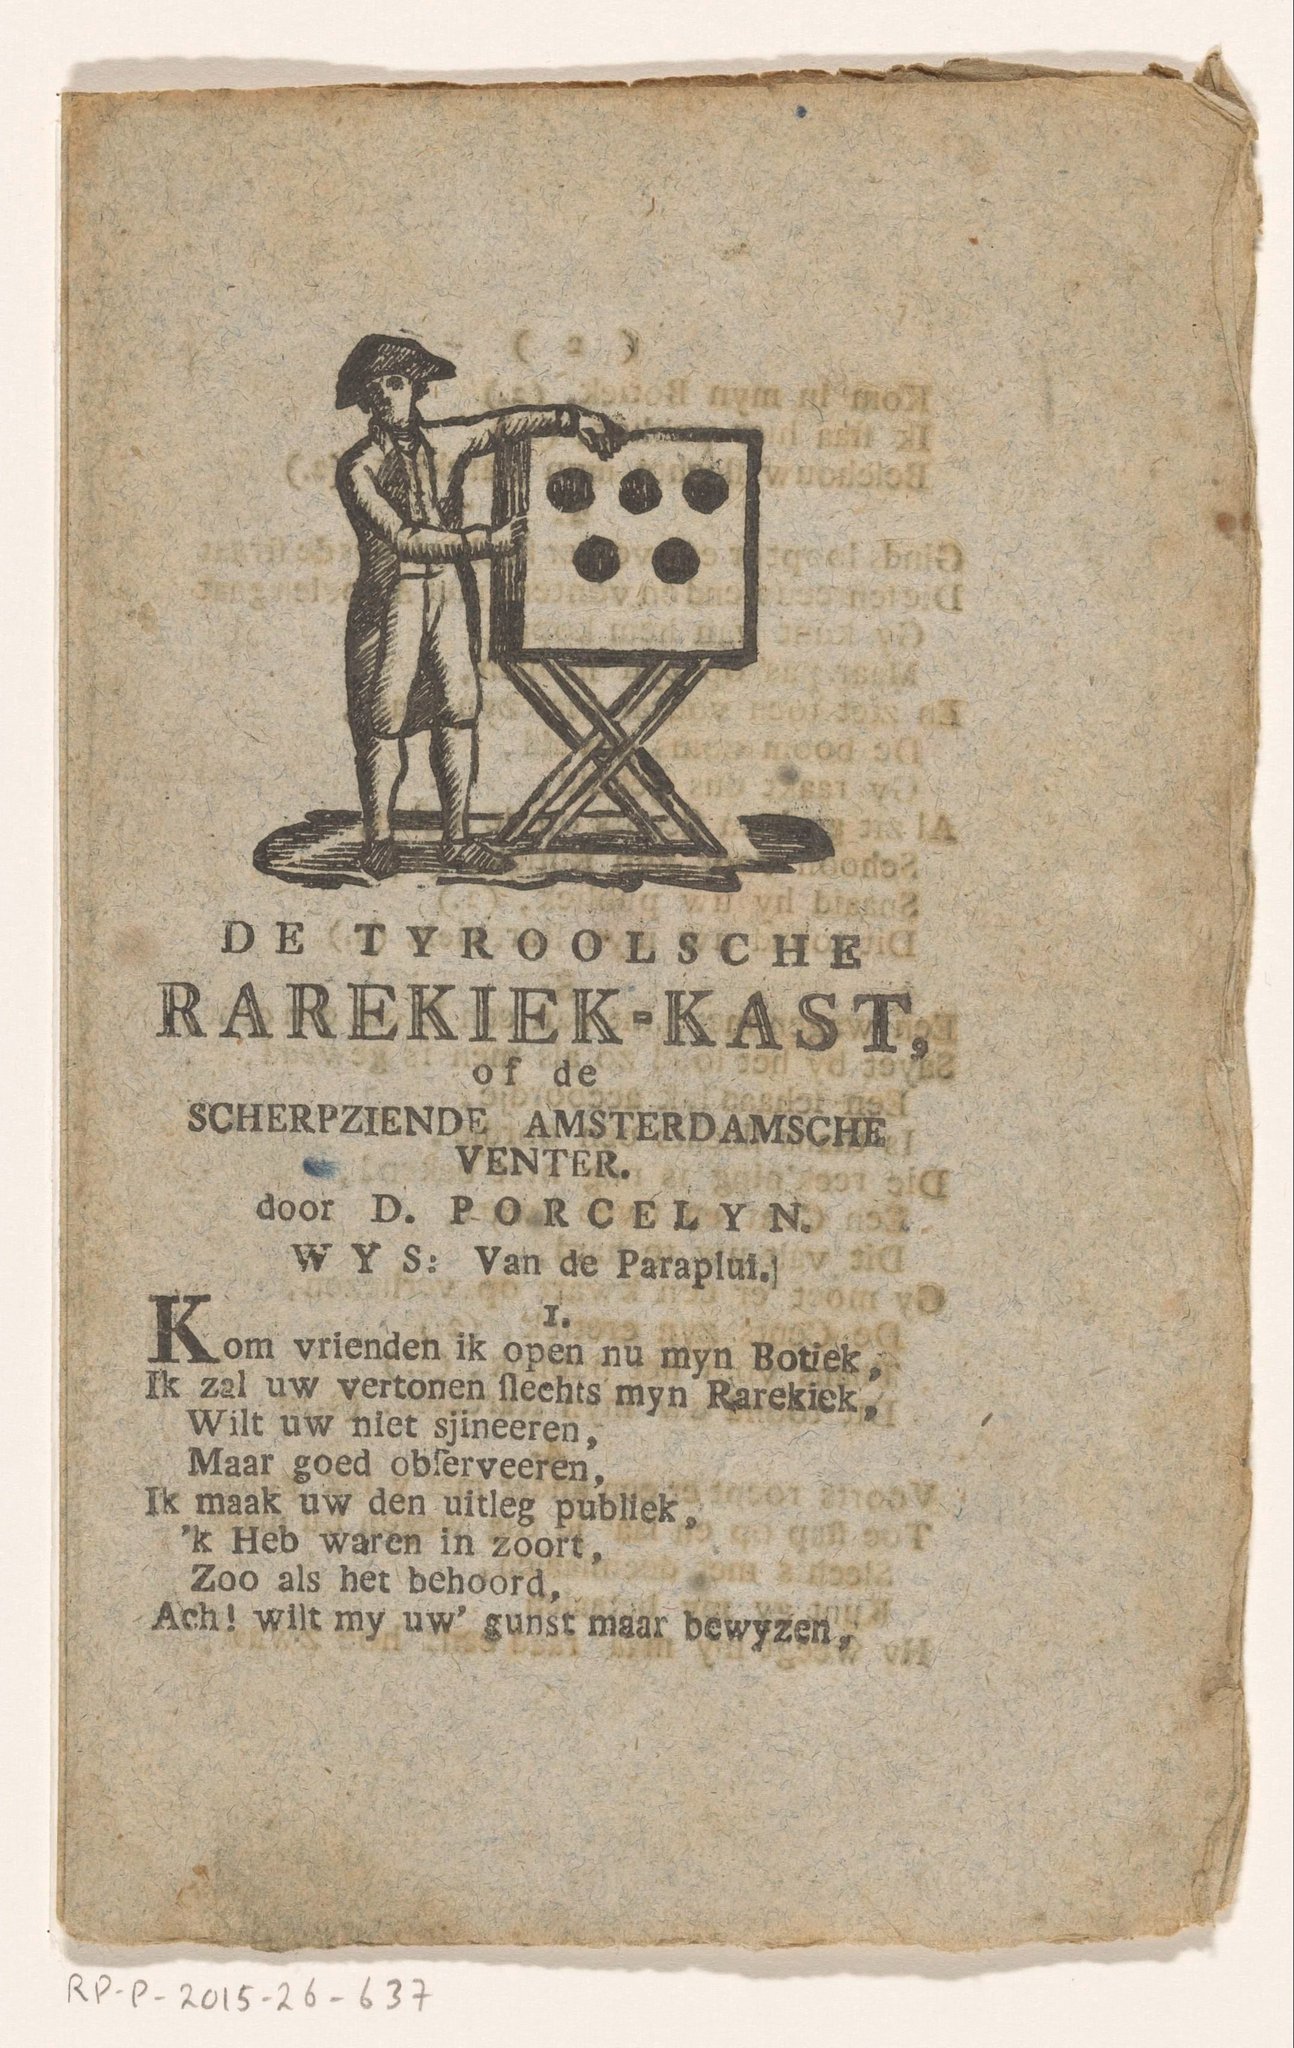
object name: print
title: De Tyroolsche Rarekiek-Kast of de Scherpziende Amsterdamsche Venter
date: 1819-1842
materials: paper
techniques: letterpress printing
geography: amsterdam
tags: peep-show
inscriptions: collector's mark: Lugt 4779, collector's mark: Lugt 2228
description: Prent op de voorkant van een liedboekje. De Tyroolsche Rarekiek-Kast is een lied in 9 coupletten, geschreven door D. Porceleyn dat wordt gezongen op de wijs: Van de Paraplui. Het boekje bevat verder: Een Nieuw Lied en Een Nieuw Lied, of de Luije Ambagtslieden.